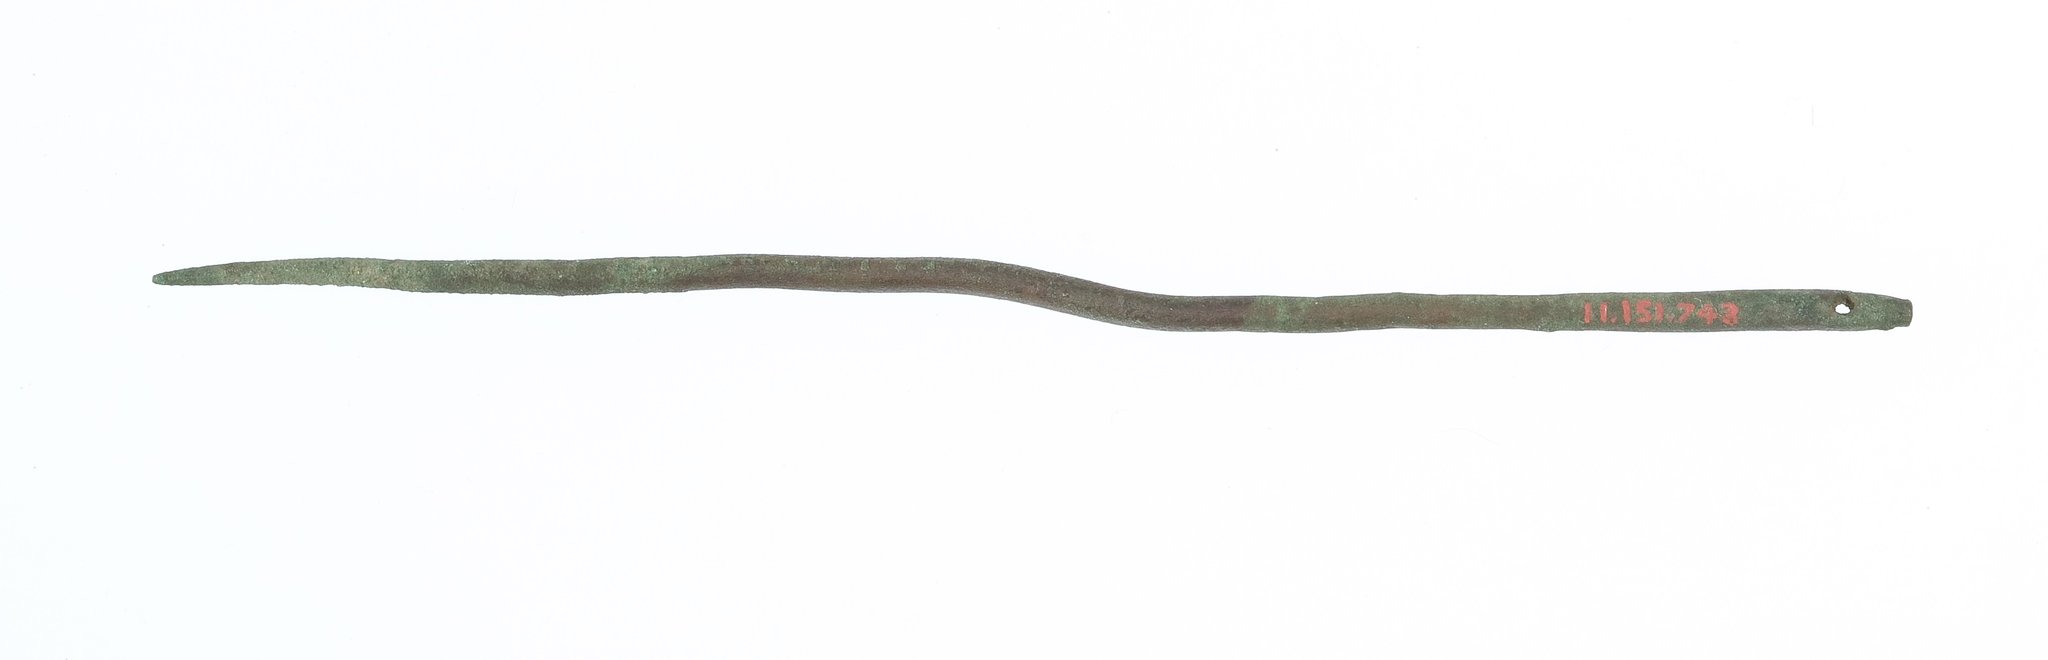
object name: needle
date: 1295-1070 BCE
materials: bronze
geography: egypt